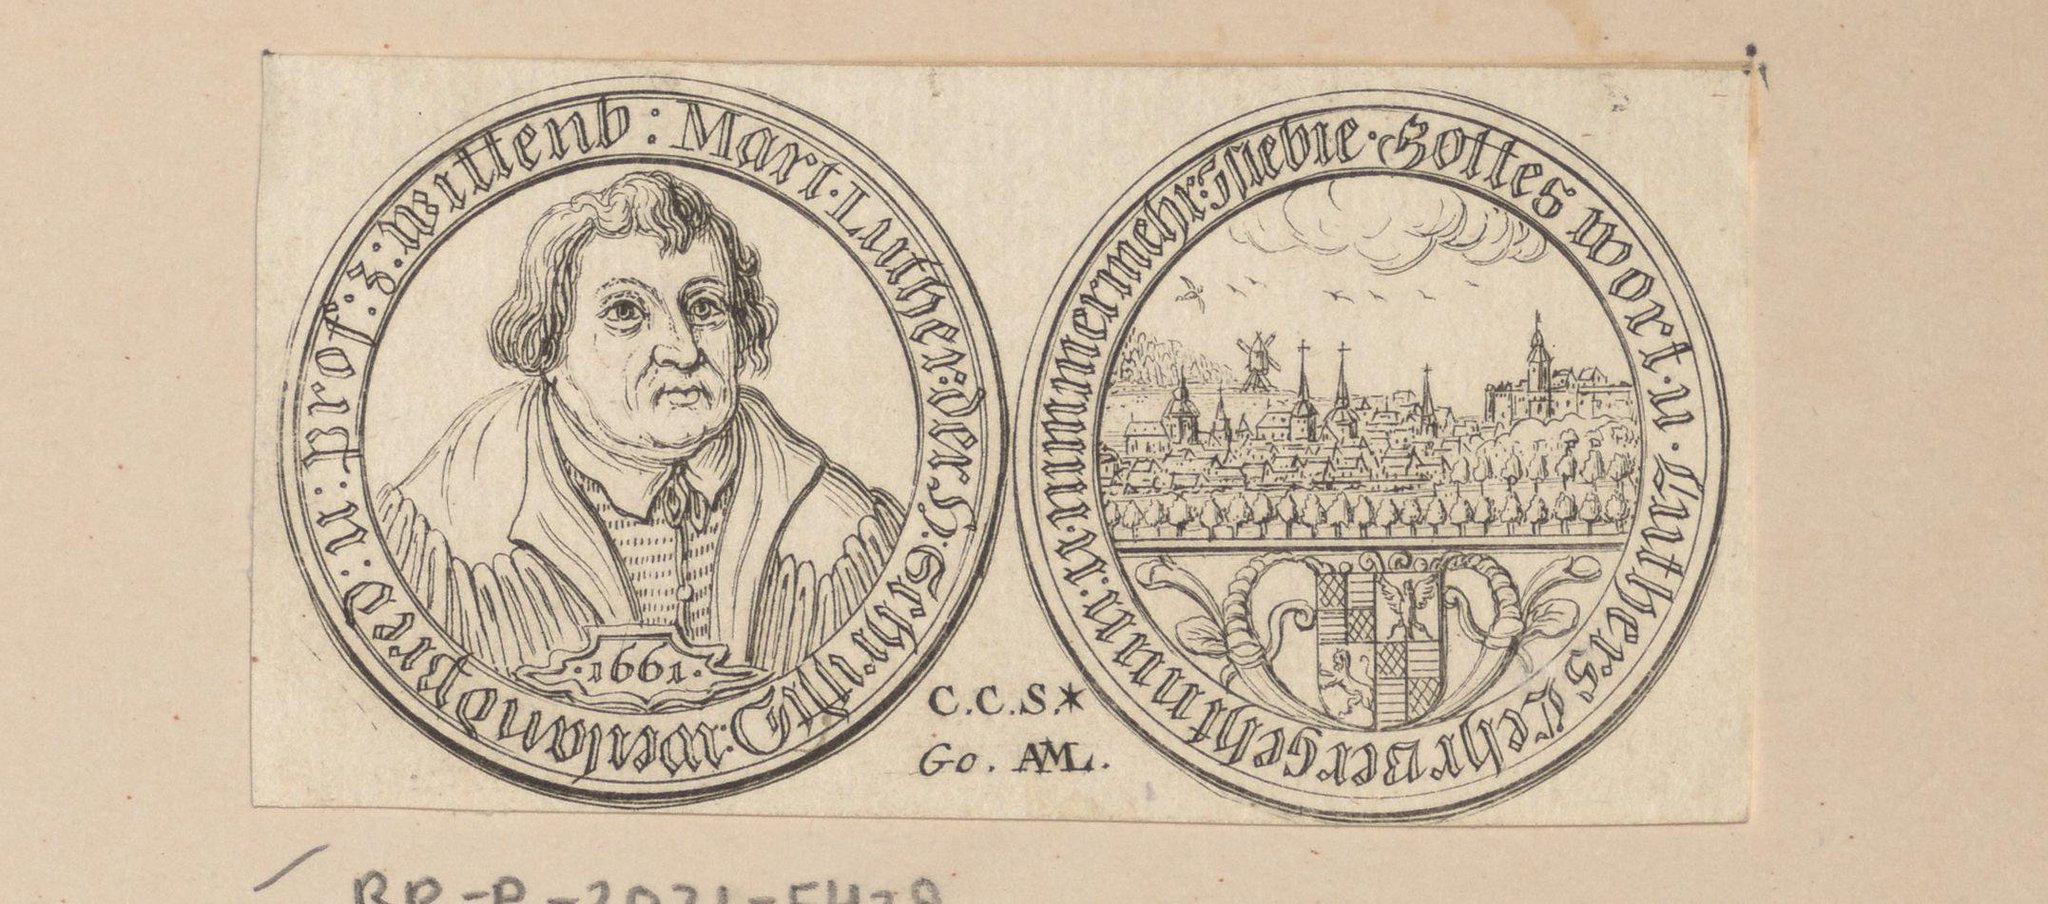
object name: print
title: Voor- en achterzijde van een penning met het portret van Martin Luther en gezicht op Eisleben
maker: Anonymous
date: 1728-1734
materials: paper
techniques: etching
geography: northern netherlands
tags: priest, martin luther, city-view, and landscape with man-made constructions, theologian, historical persons, medal (considered as a piece of sculpture, regardless of its specific function), armorial bearing, heraldry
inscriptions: monogram: ‘AML’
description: Prent met tekst in boekdruk op verso gebruikt in: Seckendorf, Veit-Ludwig von. Uitvoerige en onpartydige historie der reformatie door dr. Martin Luther (...). Delft: Reinier Boitet, 1728. En in de druk uit 1730, en mogelijk ook al in 1726. En in: Juncker, Christian. De goude en zilvere eergedagtenis van Dr. M. Luther (...). Den Haag: s.n., 1734. De monogrammen op de prent verwijzen naar de eigenaren van de penning.